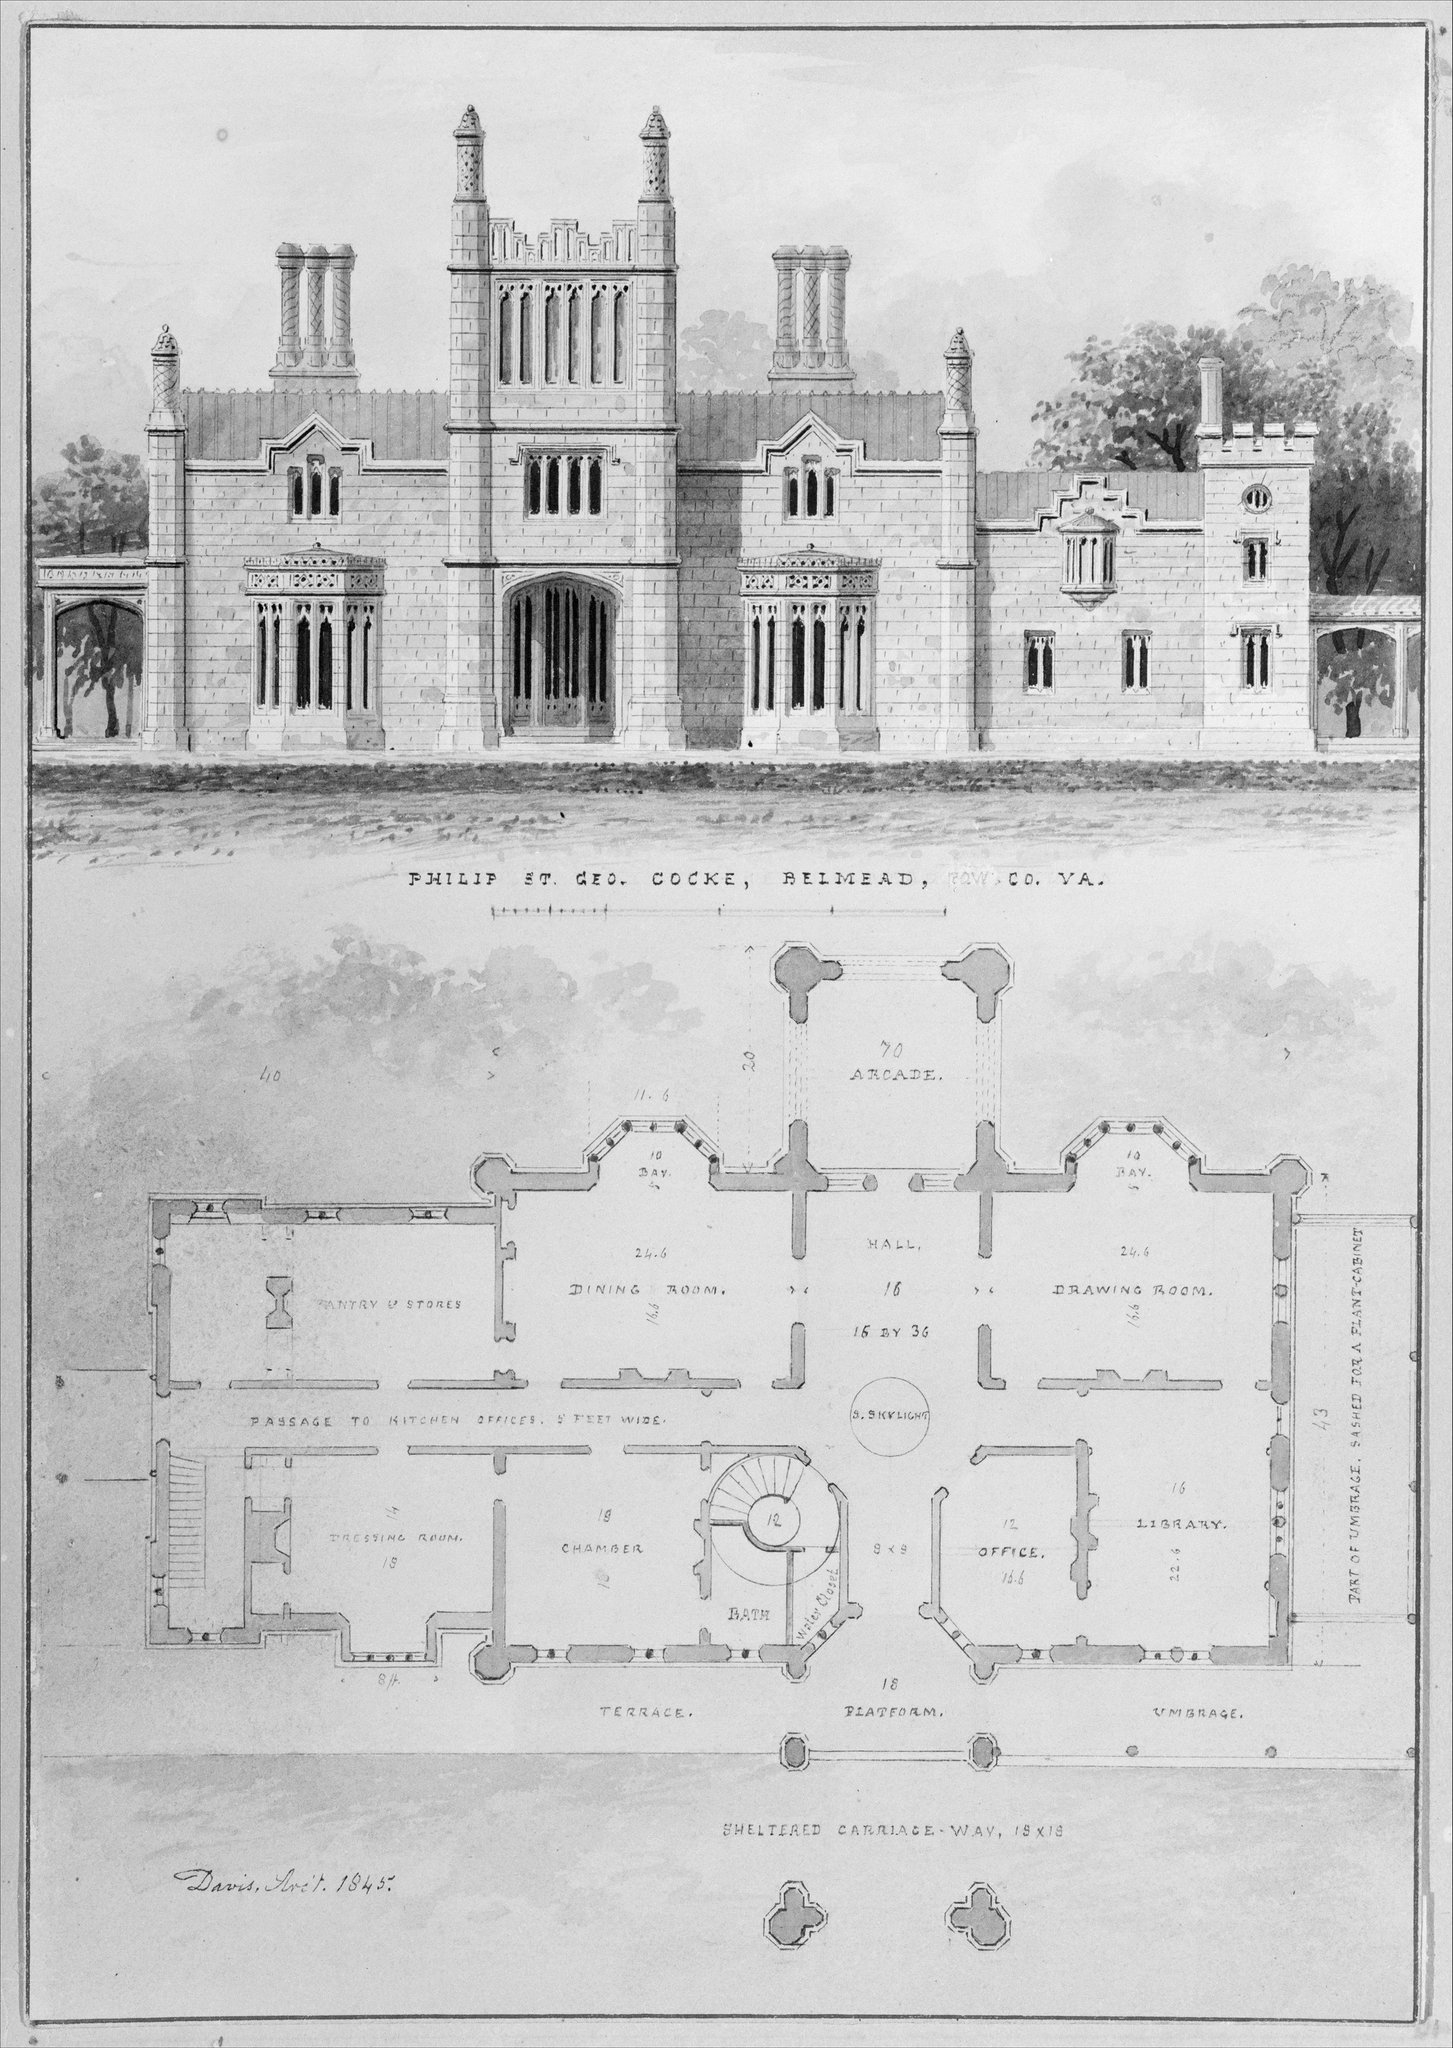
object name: drawing ornament architecture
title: Belmead, for Philip St. George Cocke, Powhatan Co., Virginia (elevation and plan)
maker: alexander jackson davis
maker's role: artist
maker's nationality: american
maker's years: 1803-1892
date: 1845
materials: ink, watercolor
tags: houses